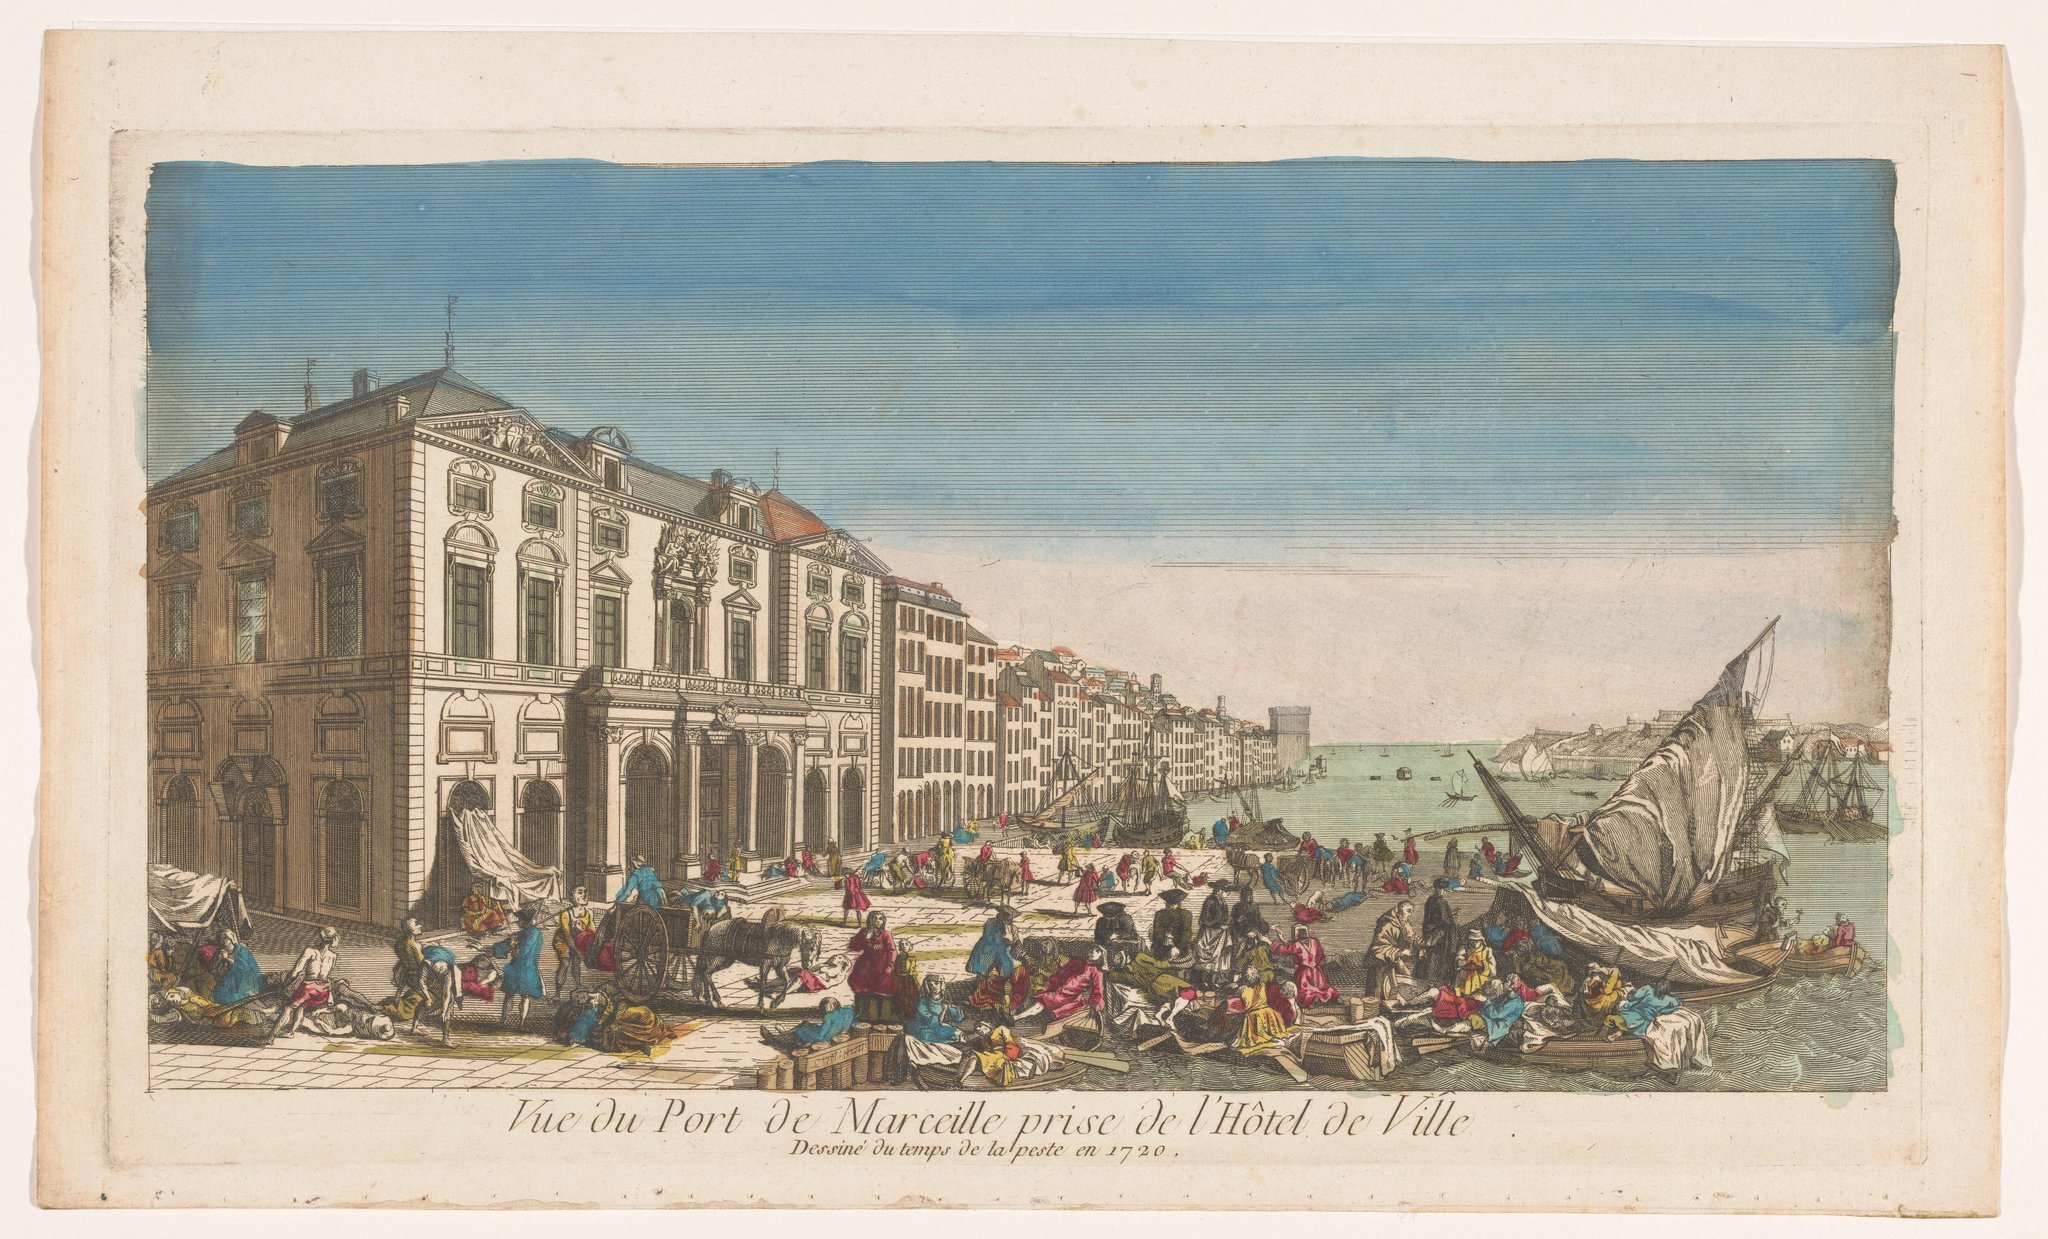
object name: print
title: Gezicht op het Stadhuis en de haven te Marseille met slachtoffers getroffen door de pest in 1720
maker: Anonymous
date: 1720-1799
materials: paper, watercolor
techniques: brush, etching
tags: harbour, sailing-ship, sailing-boat, rowing-boat, canoe, etc., townhall, sea (seascape) (+ landscape with figures, staffage), marseille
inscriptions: collector's mark: Lugt 2166, watermark